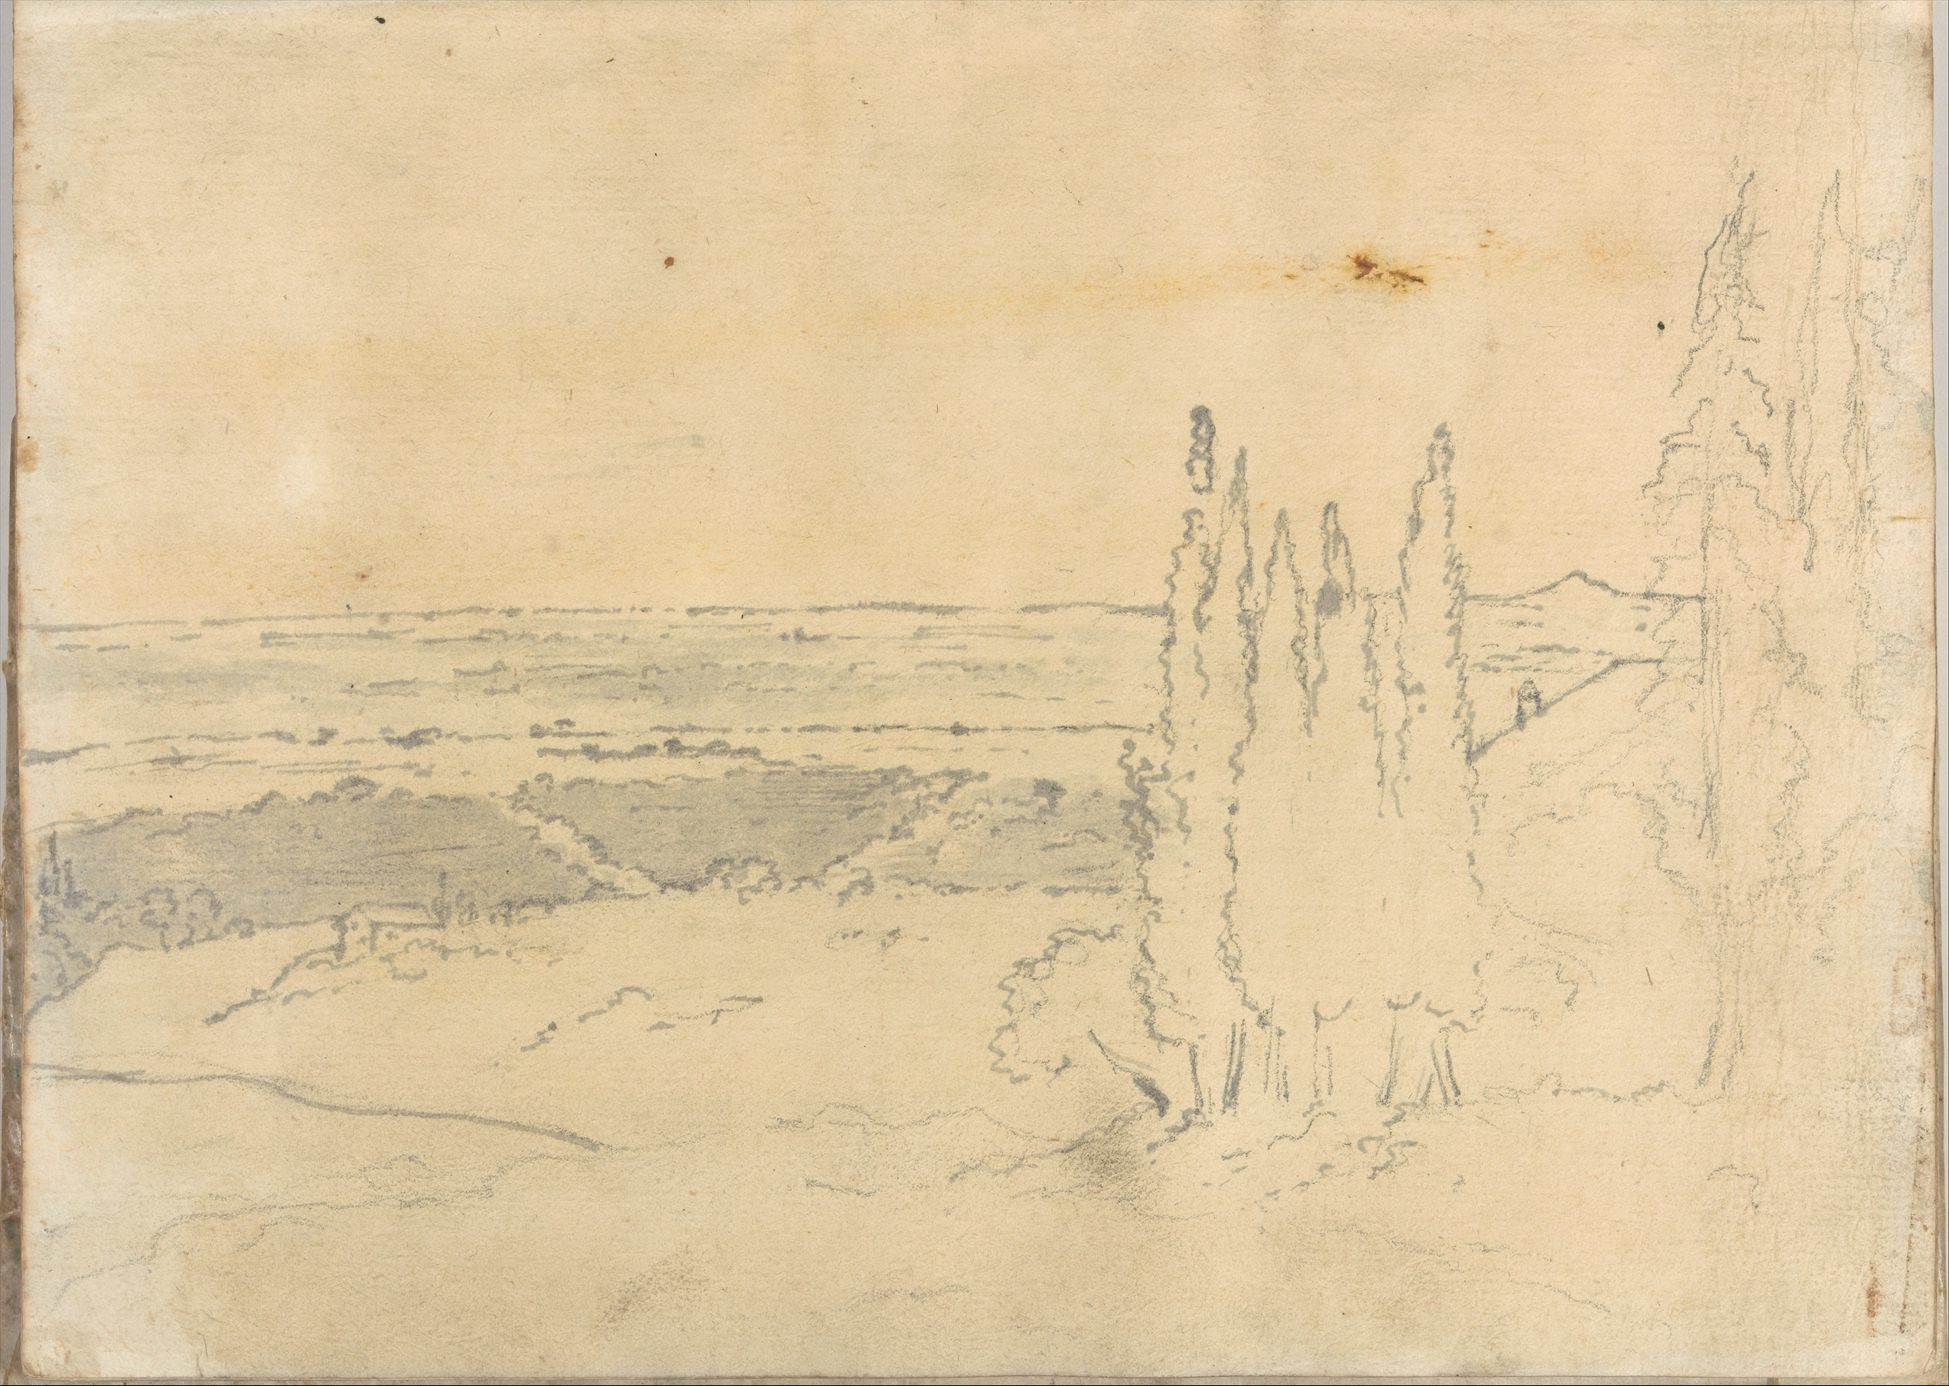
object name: drawing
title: Landscape with cedars and buildings, at Rome (Smaller Italian sketchbook, leaf 24 recto)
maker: joseph wright (wright of derby)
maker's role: artist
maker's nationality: british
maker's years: 1734-1797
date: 1774-1775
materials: graphite, ink, watercolor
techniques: brush, pen, wash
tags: landscapes